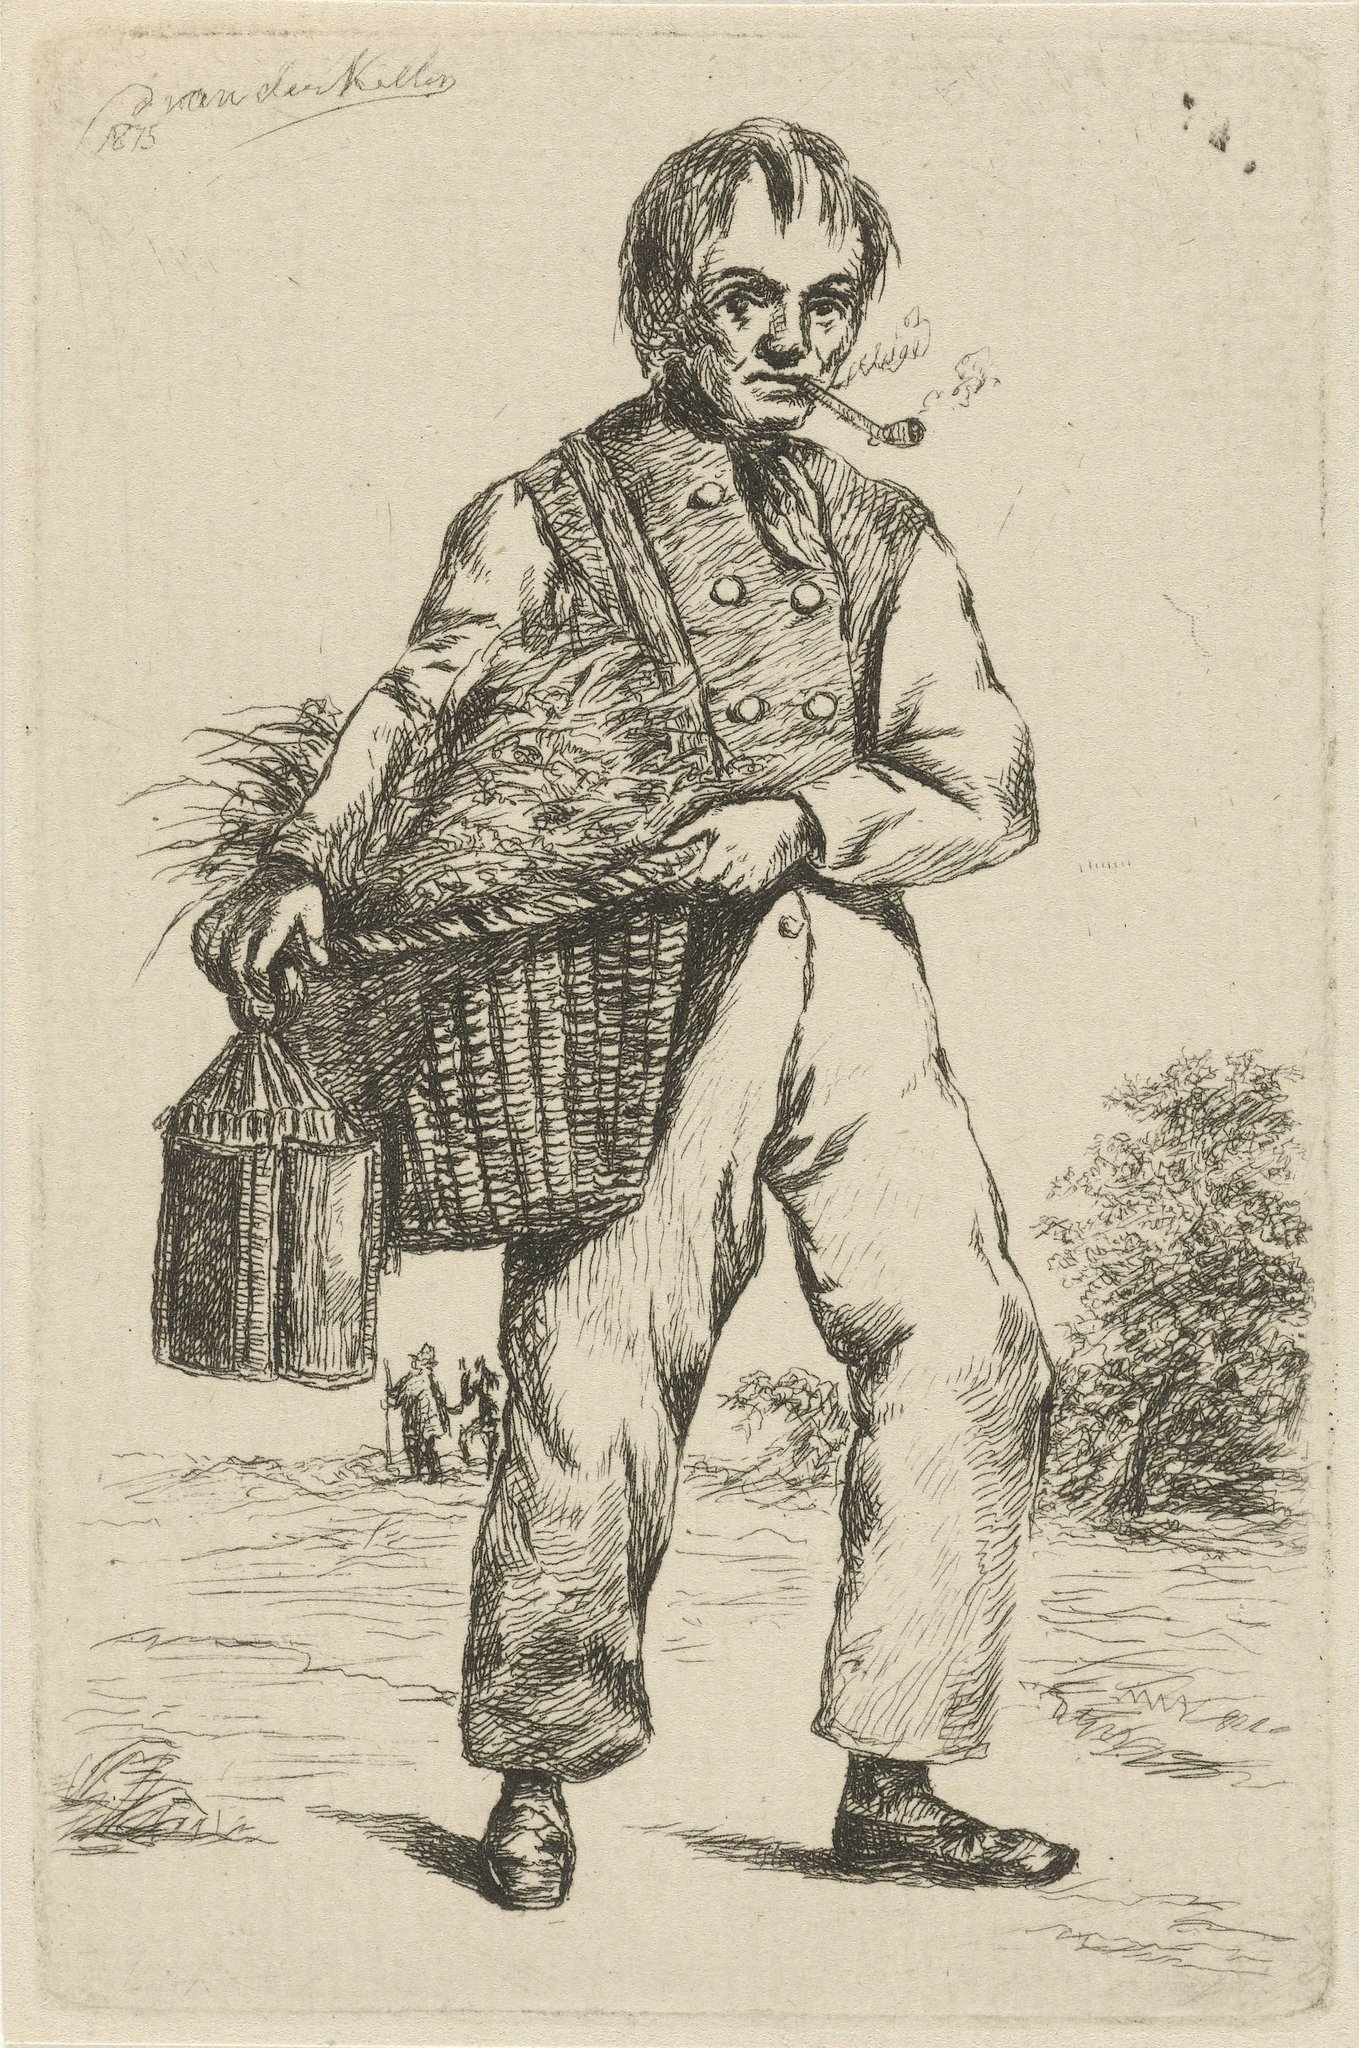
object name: print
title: Twee mannen in een tuin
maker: david van der kellen (1804-1879)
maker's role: die cutter, draughtsman, print maker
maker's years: 1804-1879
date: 1814-1878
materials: paper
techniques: etching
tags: pipe ~ tobacco, gardening, lantern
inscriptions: collector's mark: Lugt 2228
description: Met een mand onder zijn arm en een lantaarn in de hand, loopt een pijprokende tuinman in de buitenlucht. Op de achtergrond houdt een man met hoed en stok een paard aan een leidsel.